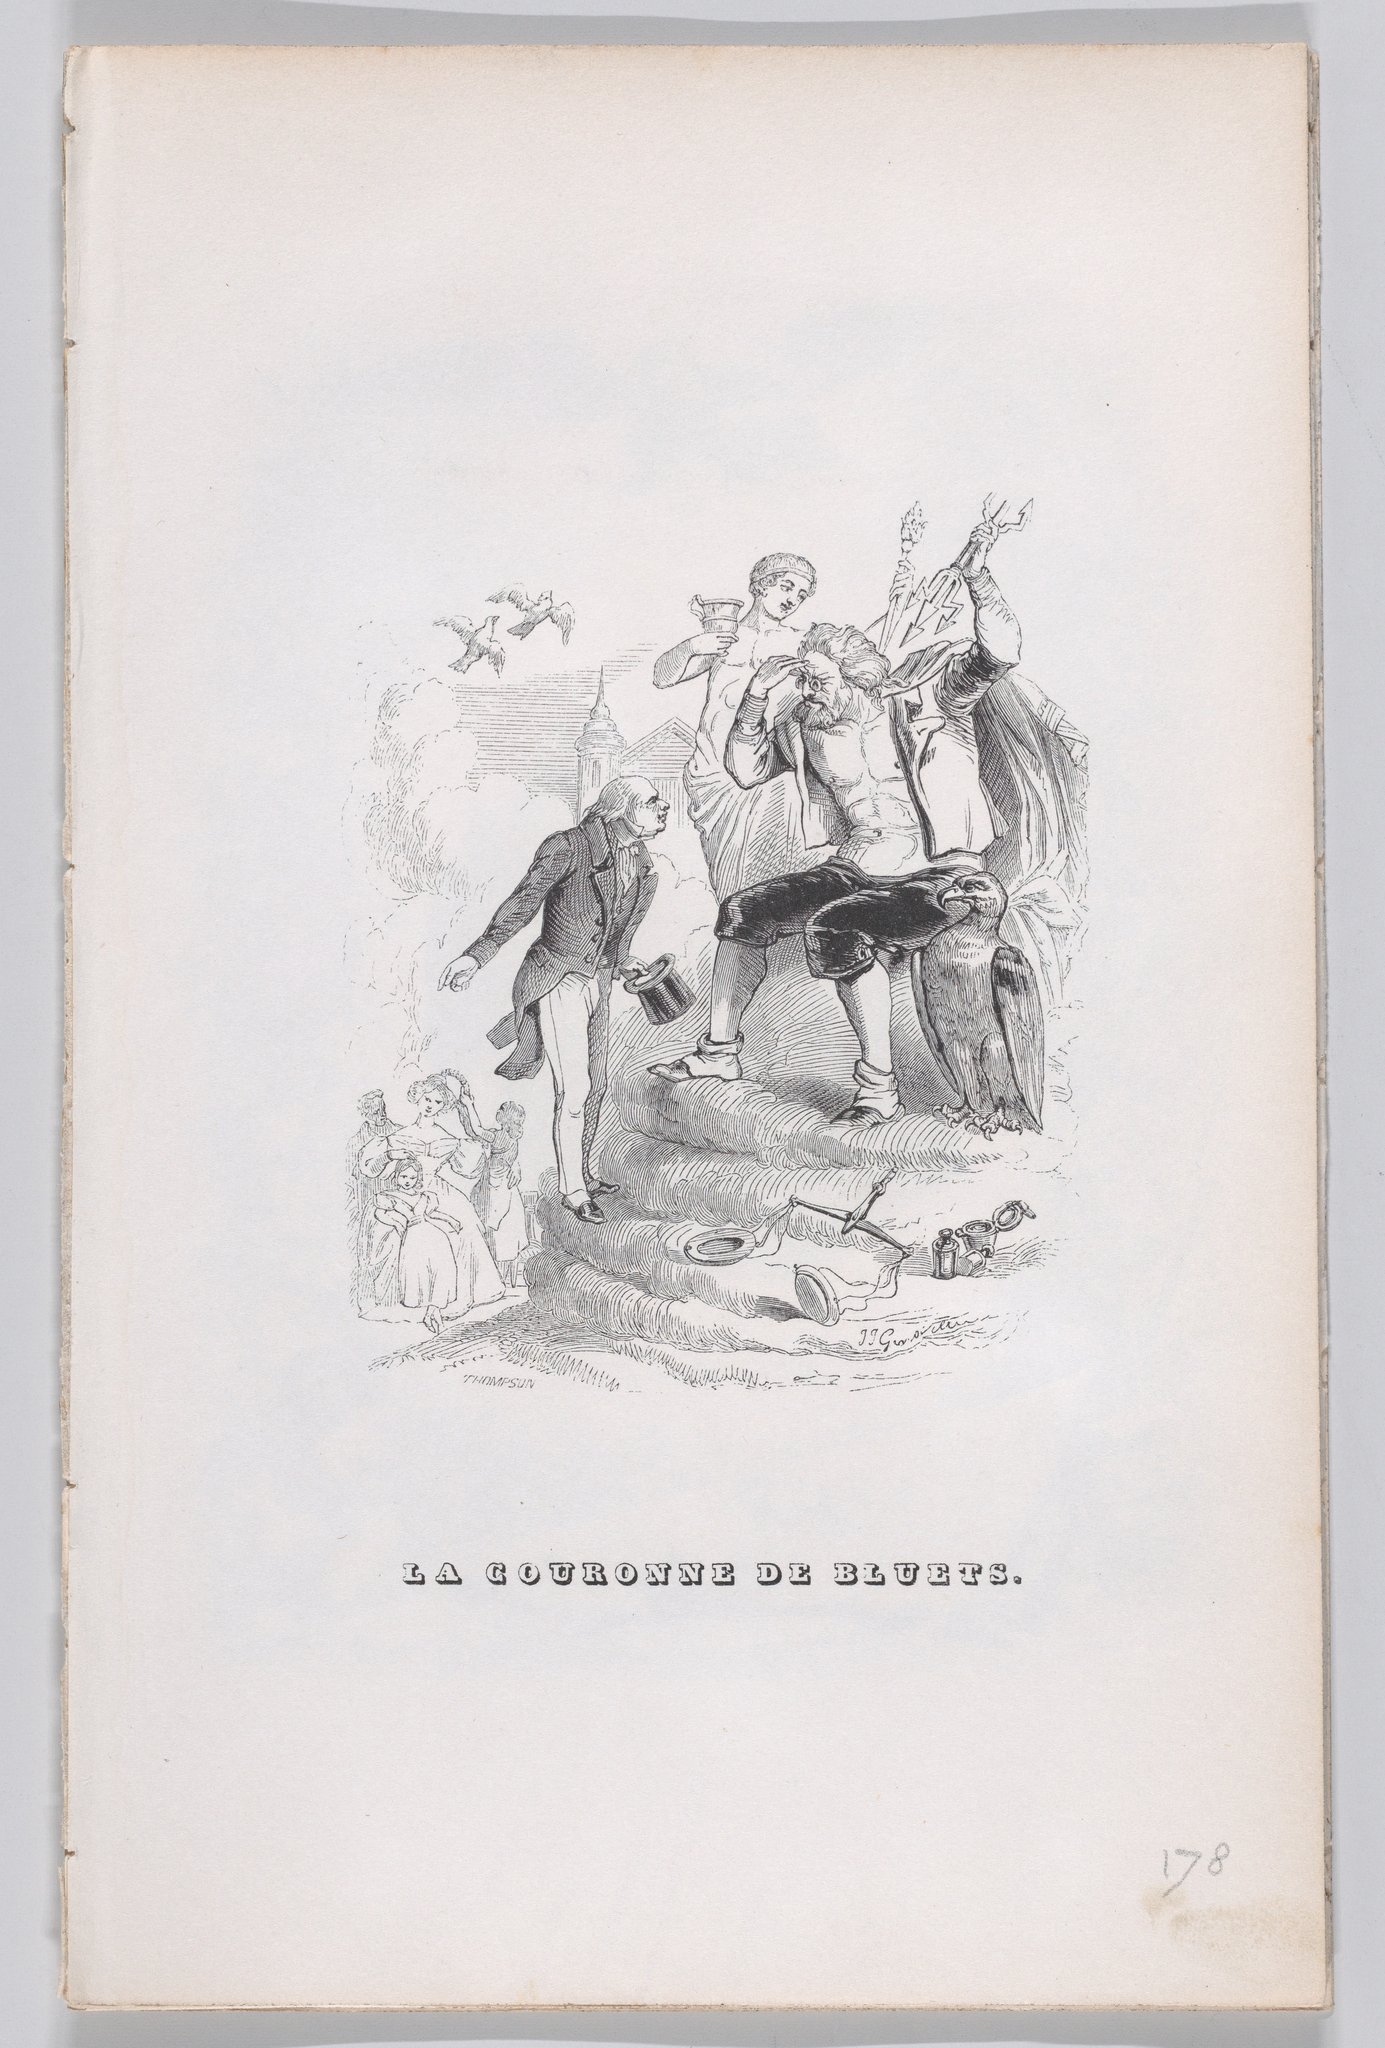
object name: print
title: Crown of Cornflowers, from "The Complete Works of Béranger"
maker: j. j. grandville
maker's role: illustrator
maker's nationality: french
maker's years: 1803-1847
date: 1836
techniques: engraving